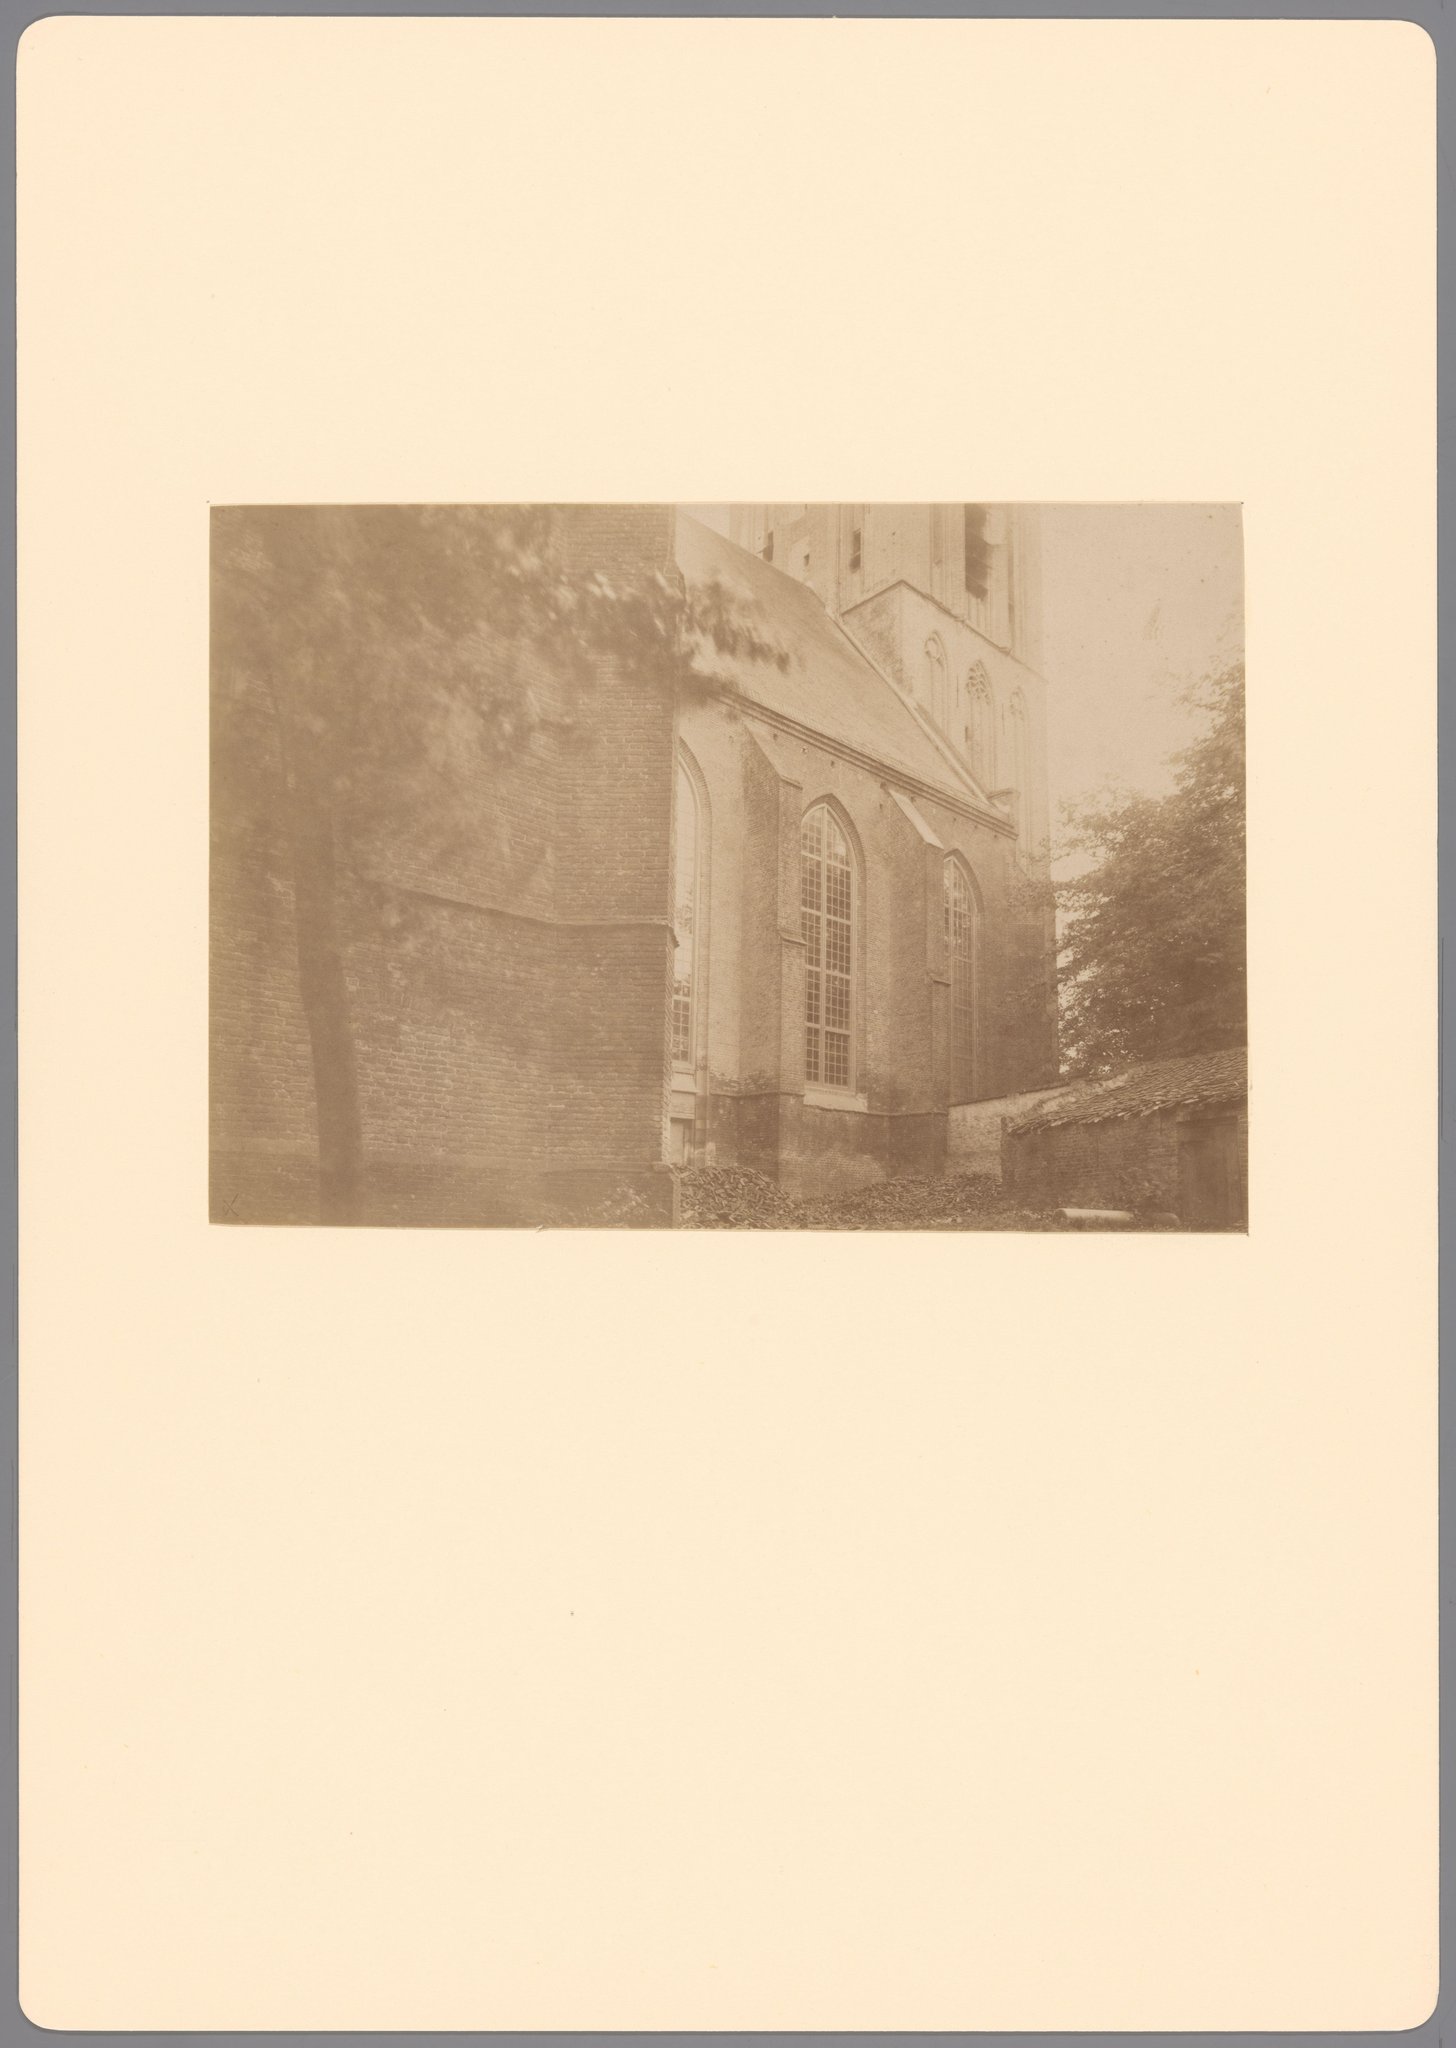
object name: photograph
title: Gedeelte van de Grote of Sint-Nicolaaskerk te Elburg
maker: anoniem (monumentenzorg)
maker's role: fotograaf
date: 1890-1920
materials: cardboard, photographic support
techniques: albumen print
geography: elburg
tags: church (exterior)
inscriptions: annotation: ‘X’